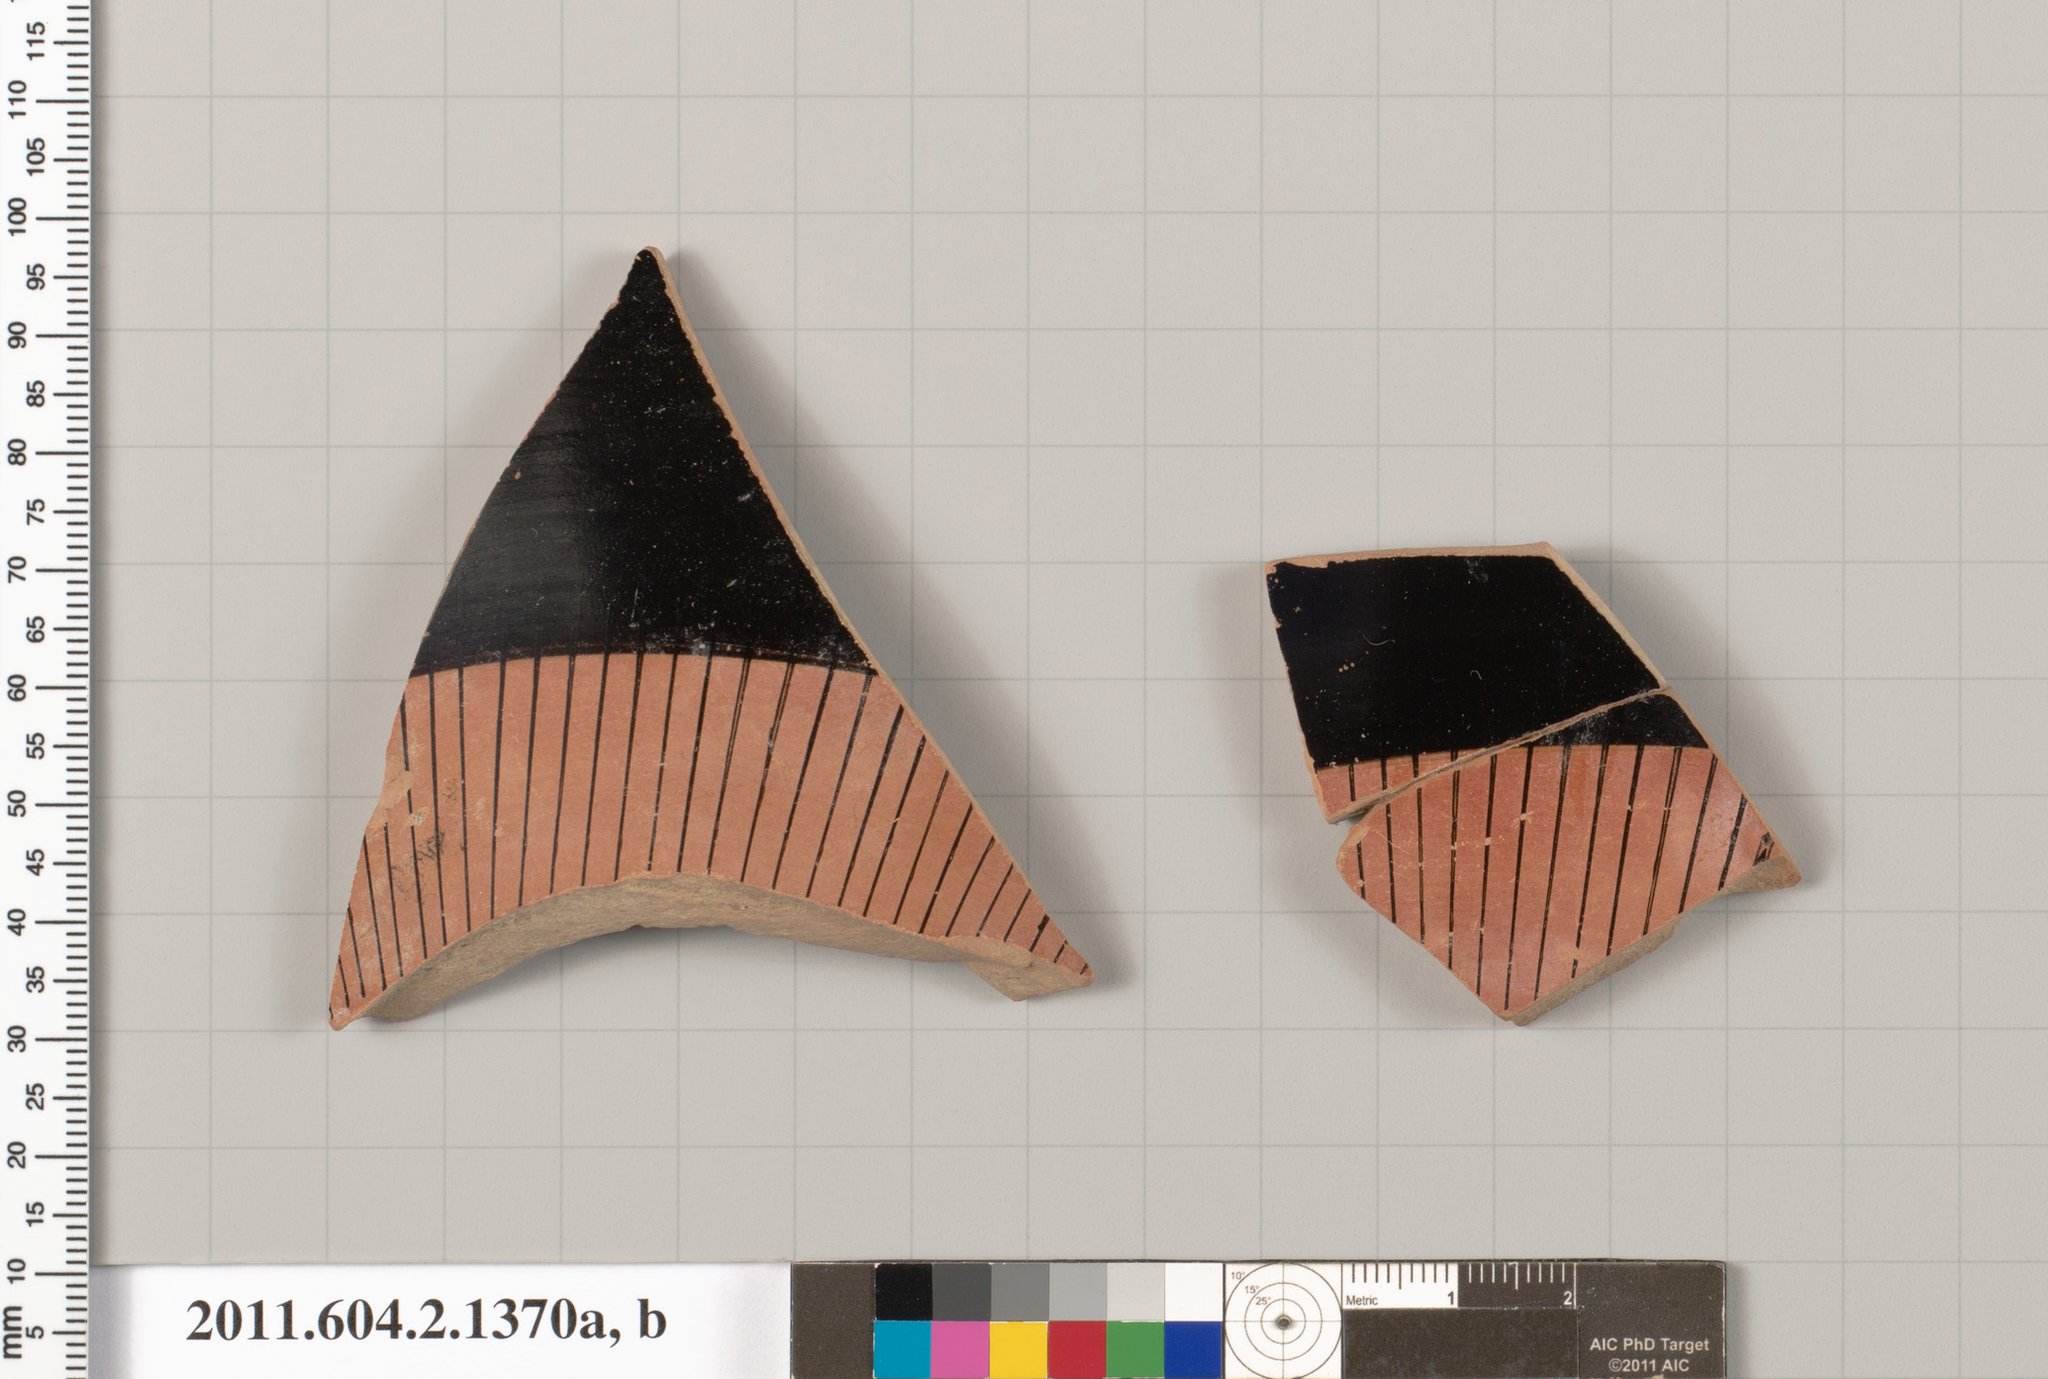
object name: skyphos fragment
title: Terracotta fragments of a skyphos (deep drinking cup)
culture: greek, attic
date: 475-451 BCE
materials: terracotta